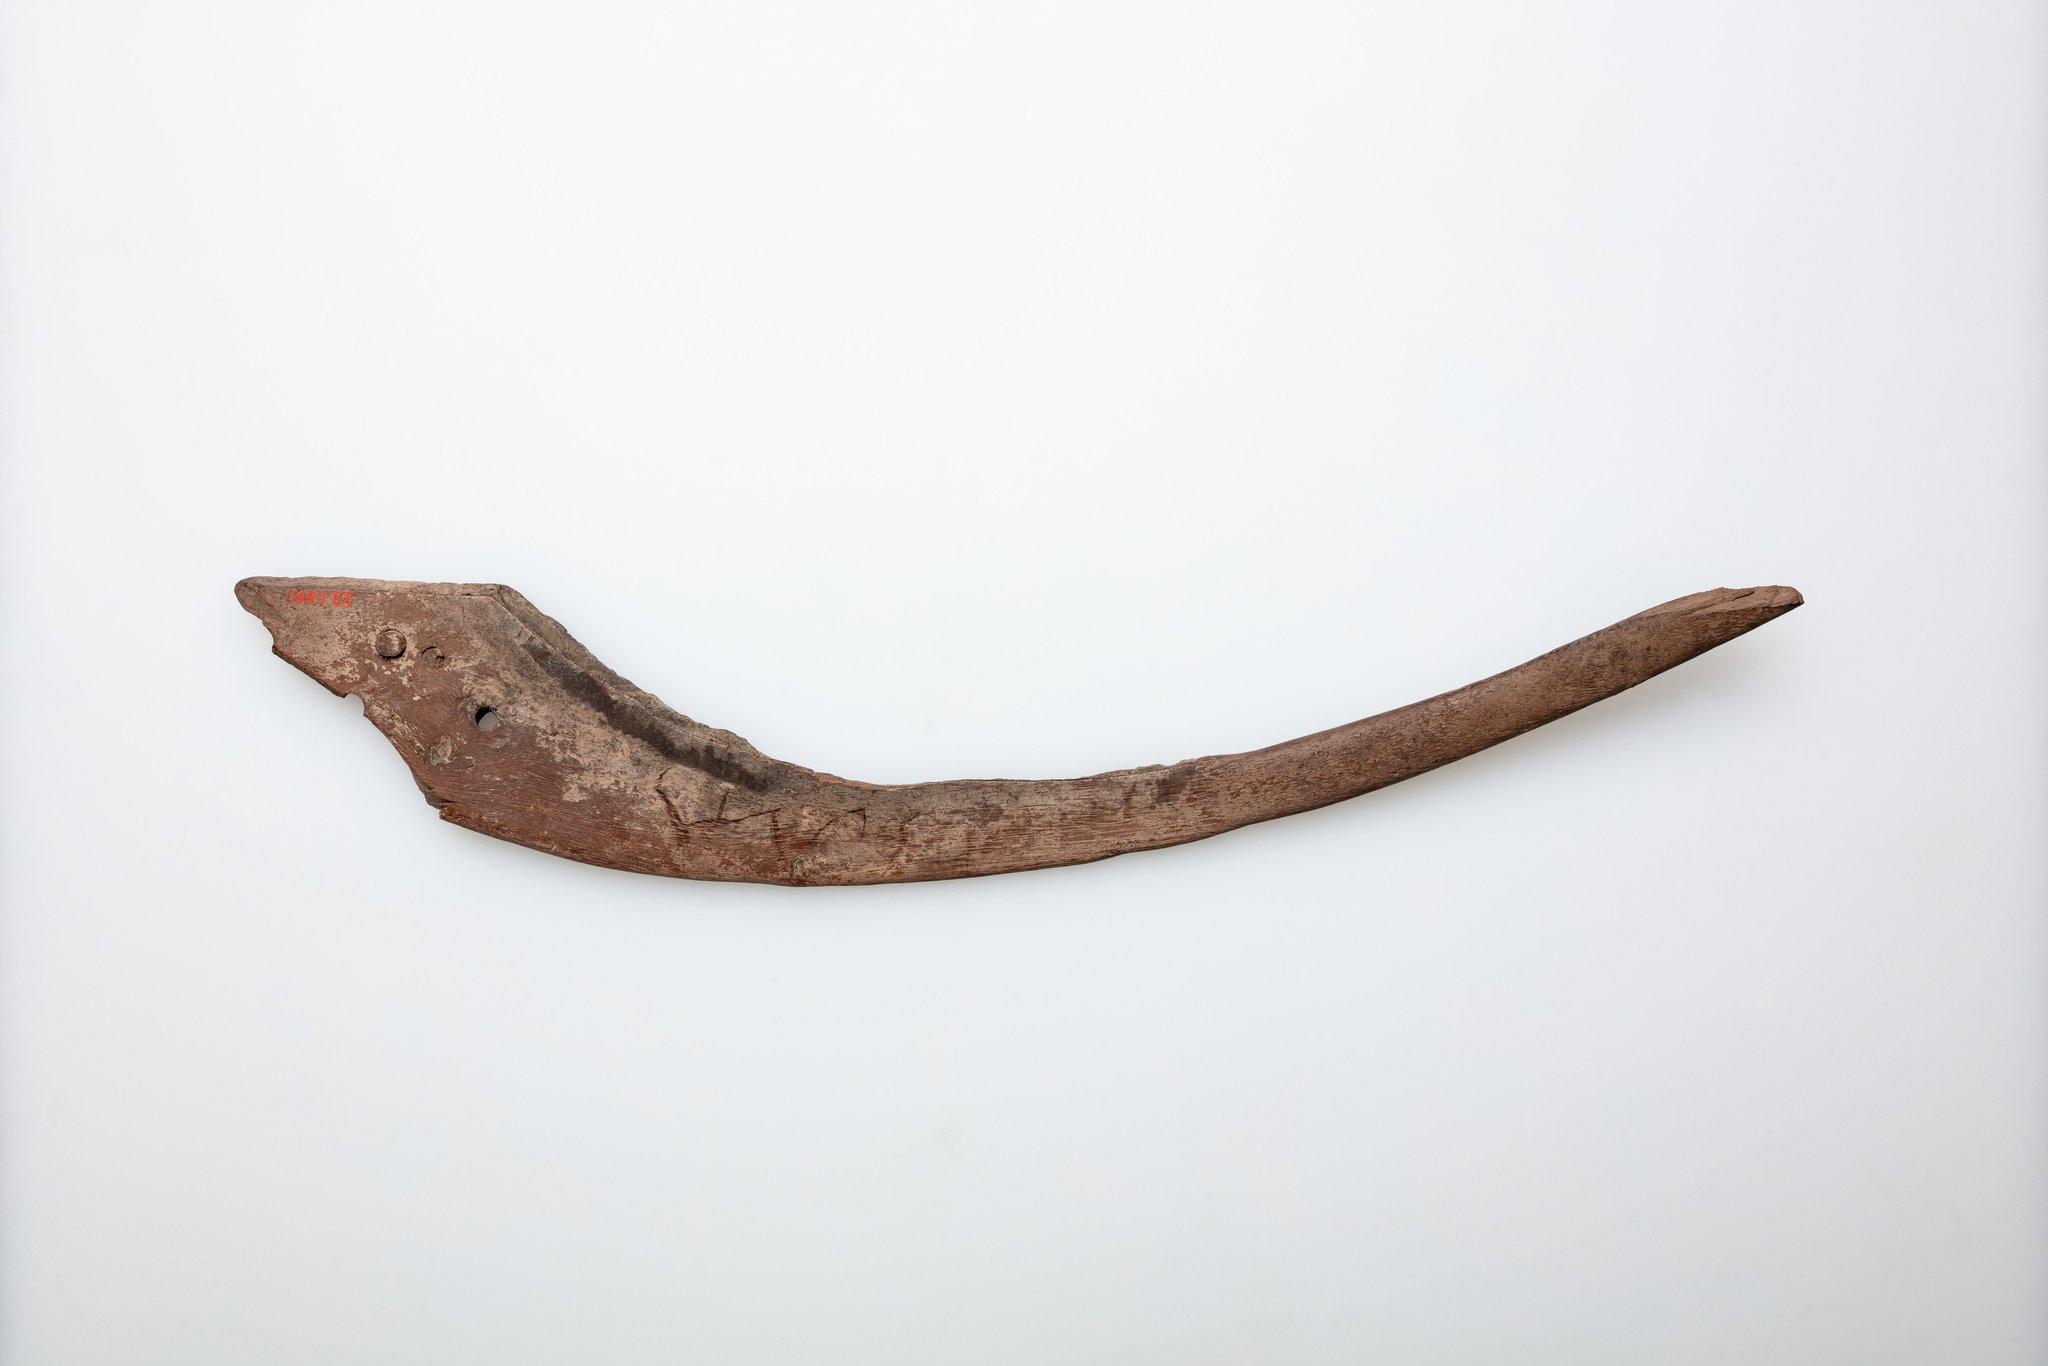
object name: sickle, haft, adhesive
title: Sickle Fragment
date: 1186-1070 BCE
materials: wood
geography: egypt